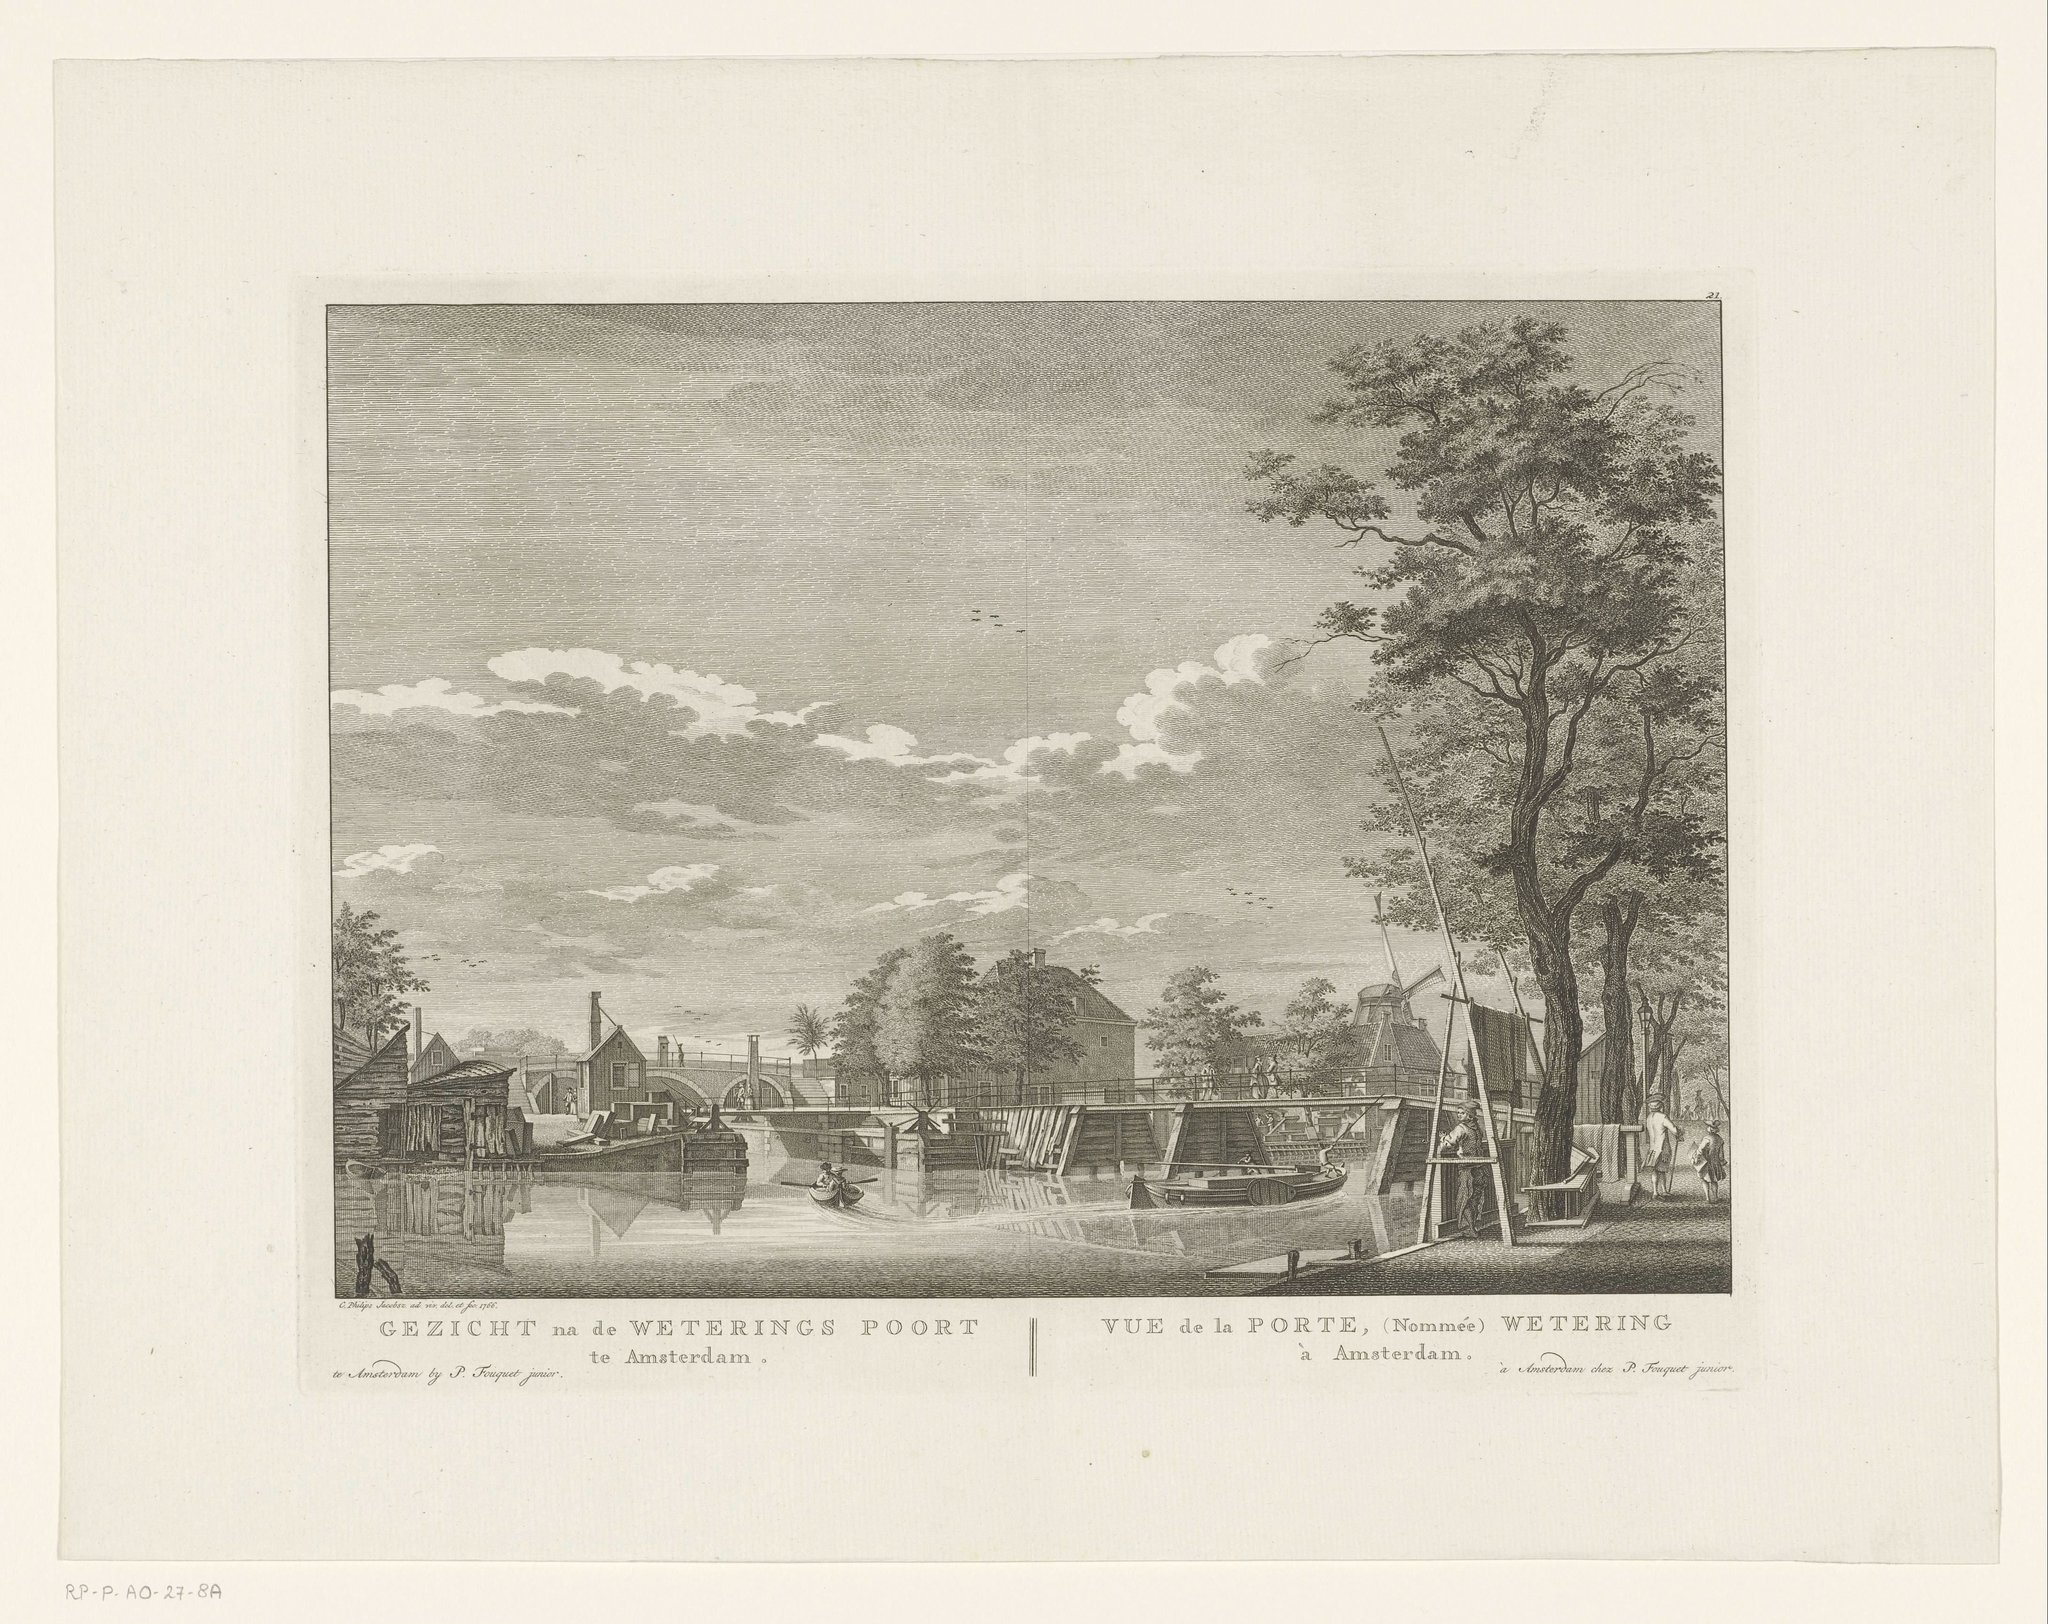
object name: print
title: Gezicht op de Weteringpoort te Amsterdam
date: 1766-1783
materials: paper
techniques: engraving, etching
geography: amsterdam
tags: bridge in city across river, canal, etc. (+ city(-scape) with figures, staffage), city-gate, canals, waters (in city) (+ city(-scape) with figures, staffage), street (+ city(-scape) with figures, staffage)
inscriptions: collector's mark: Lugt 2228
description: Deze prent is ook gebruikt in de zogenaamde Atlas van Fouquet.* Pierre Fouquet gaf vanaf 1760 stadsgezichten van Amsterdam - naar tekeningen van verschillende kunstenaars, gemaakt door verschillende prentmakers - uit. Deze prenten werden aanvankelijk los of in series verkocht. Zoals toen gebruikelijk kon de koper de prenten zelf laten inbinden. Hiertoe gaf Fouquet tussen 1778 en 1783 een titelblad, plattegrond en inhoudsopgave van de tot dusver 100 uitgegeven prenten uit (1). Gezien de inhoud afhankelijk was van wat de koper had verzameld verschilt de inhoud van de verschillende bewaarde Fouquetatlassen onder deze titel sterk. Ook zijn er exemplaren bekend waar tevens andere prenten aan zijn toegevoegd. Omdat er behoefte bleek aan uitleg bij de platen werd in 1783 een nieuwe versie van de atlas uitgegeven, aangevuld met tekst en twee prenten. De aangegeven volgorde veranderde maar de platen van de al eerder uitgegeven prenten bleven ongewijzigd. Deze uitgave werd in opdracht van Fouquet gedrukt bij Daniël Jean Changuion en Petrus den Hengst (2). Een tiental platen werd bijgewerkt en verscheen, met nieuw impressum, in het vervolg van Wagenaars geschiedenis van Amsterdam, uitgeven door Petrus Conradi en Folkert van der Plaats (3). Een aantal jaar na het overlijden van Fouquet kwam Evert Maaskamp met een nieuwe uitgave van de atlas, met verbeterde tekst en toevoeging van twee prenten. Op alle platen verwijderde hij het oude en liet hij zijn eigen impressum zetten (4). De huidige staat van de prent komt voor in exemplaren van de onder (1) en (2) genoemde werken. * Onder de Atlas van Fouquet of Fouquetatlas verstaan we de hieronder vermelde publicaties (1), (2) en (4). (1). Afbeeldingen van de wyd-vermaarde koopstad Amsterdam benevens des zelvs voornaamste gebouwen en gezigten alle naar het leeven getekend / Receuil des edifices les plus considerables et des plus belles vues, de la fameuse ville d'Amsterdam, dessinées d'après nature. Amsterdam: Pierre Fouquet, 1778-1783. (2). Nieuwe atlas, van de voornaamste gebouwen en gezigten der stad Amsterdam, met derzelver beknopte beschryvingen. 2 delen. Amsterdam: Daniël Jean Changuion en Petrus den Hengst [in opdracht van Pierre Fouquet], 1783. (3). Stijl, Simon. Amsterdam, in zyne geschiedenissen, voorregten, koophandel, gebouwen, kerkenstaat, schoolen, schutterye, gilden en regeeringe, beschreeven. Om te dienen ten vervolge op het werk van Jan Wagenaar (…). 10 delen. Amsterdam en Harlingen: Petrus Conradi en Folkert van der Plaats, 1788-1801. (4). Nieuwe atlas, van de voornaamste gebouwen en gezigten der stad Amsterdam. Met derzelver beknopte beschryvingen. Amsterdam: Evert Maaskamp, 1805. * Het aantal vermelde staten is gebaseerd op het aantal gevonden staten. Mogelijk zijn er meer staten van deze prent.